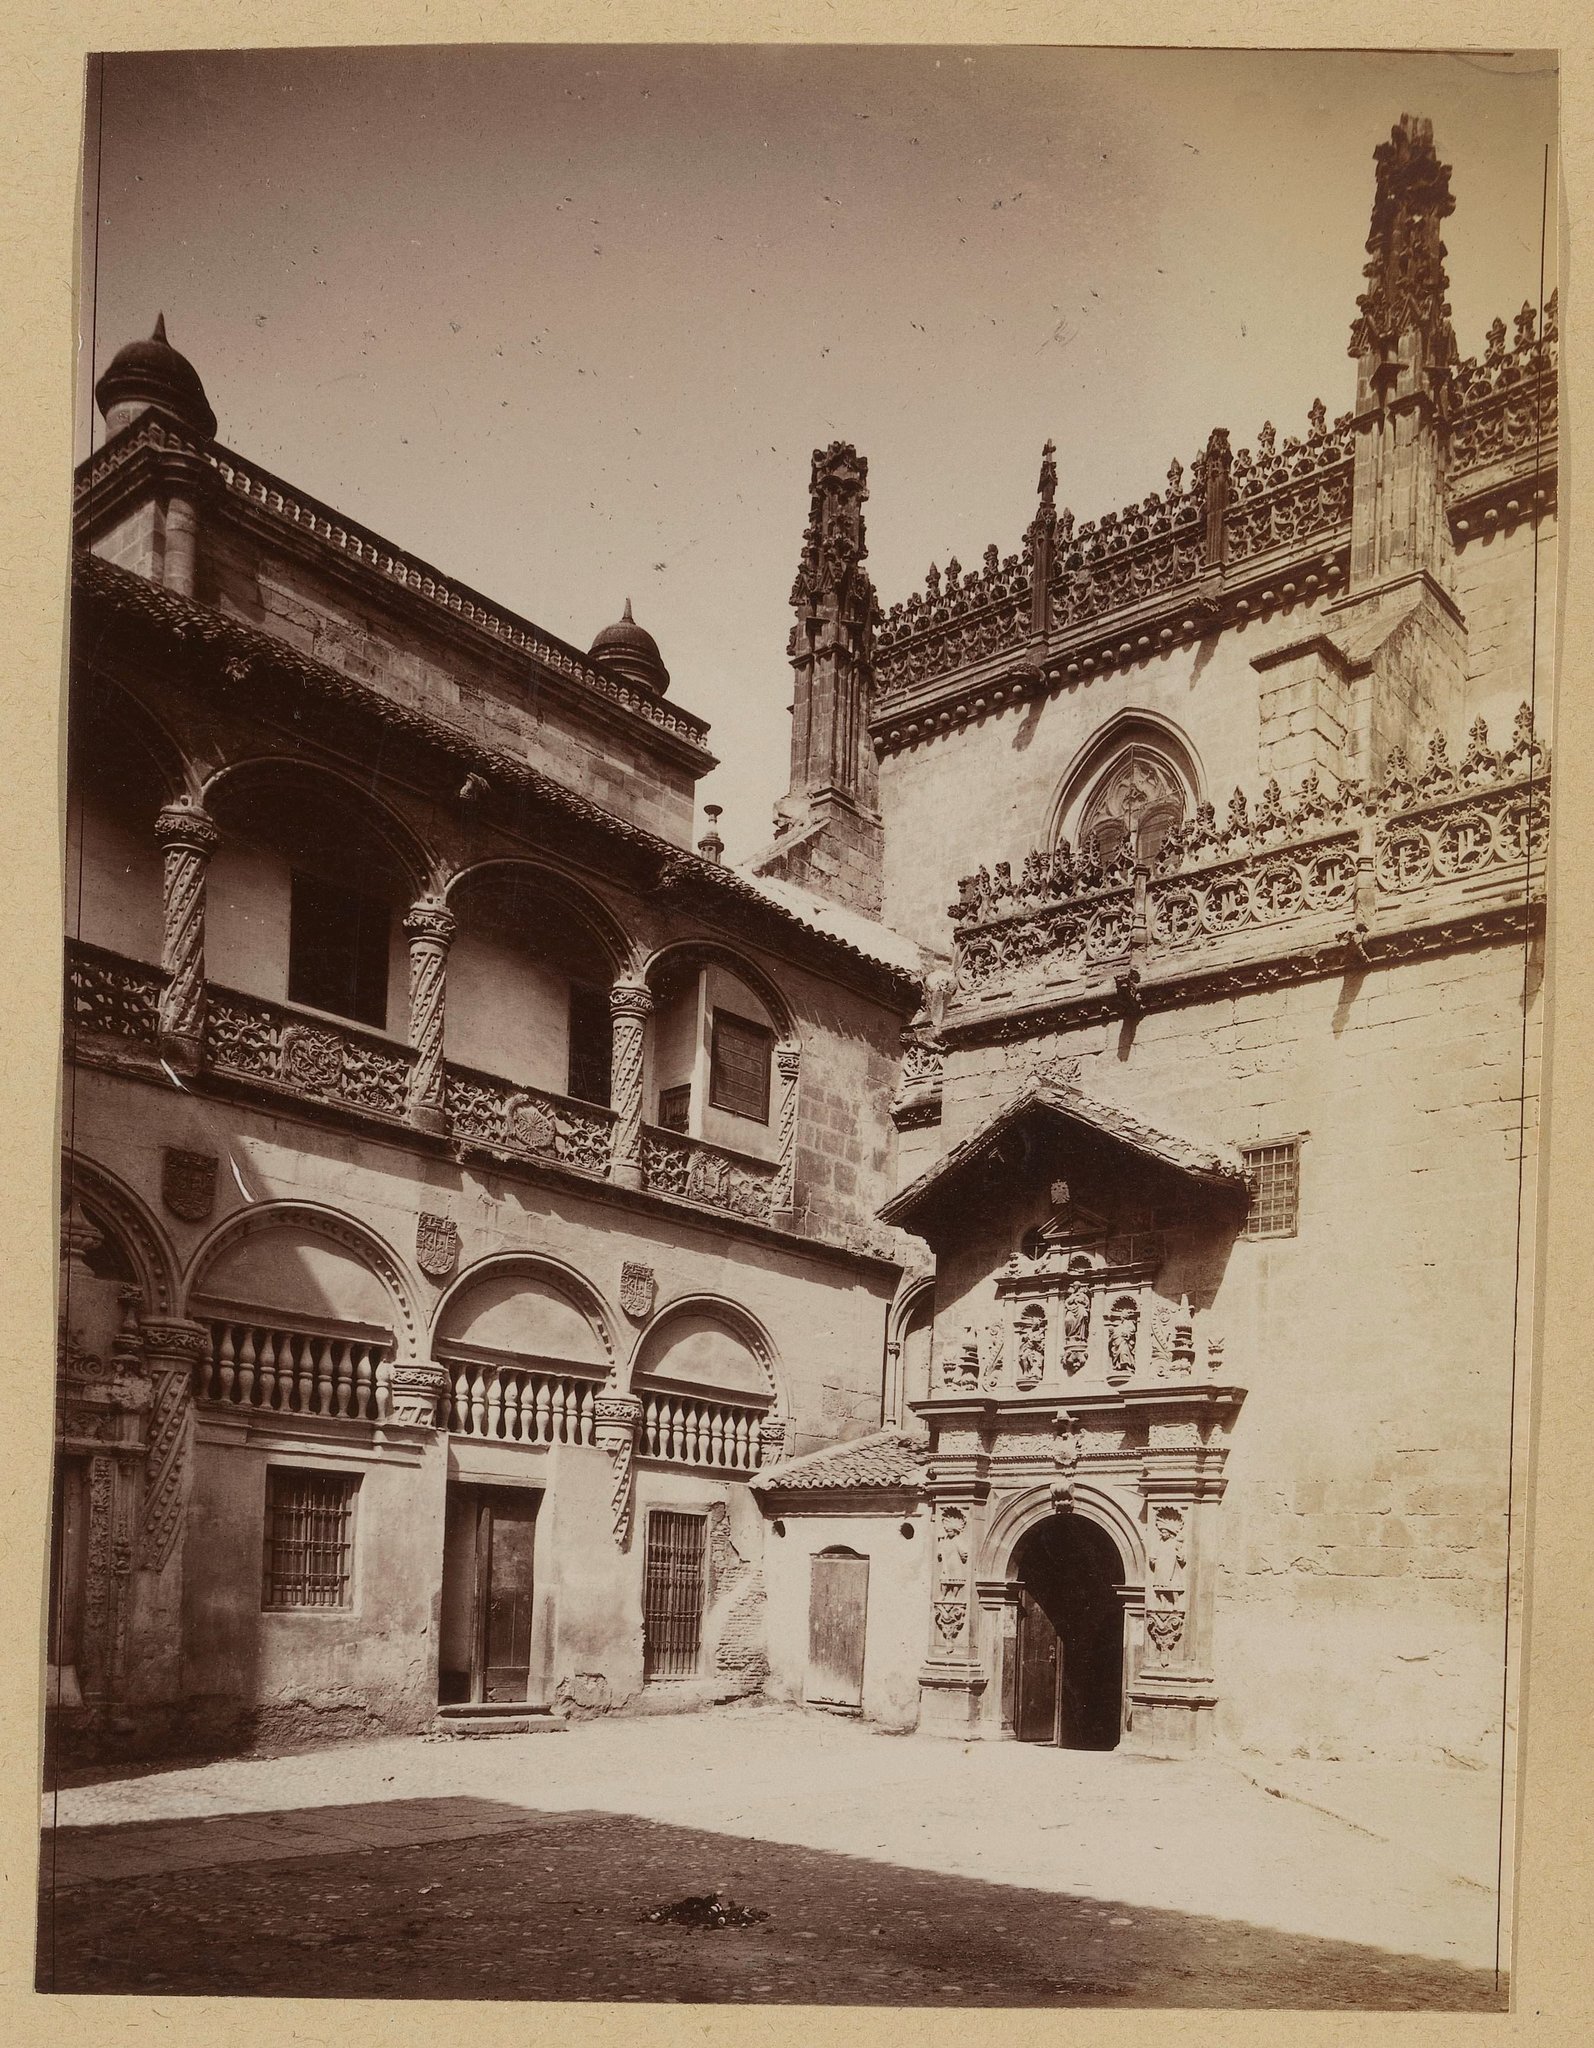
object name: photograph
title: Gezicht op de entrée van de koninklijke kapel in de kathedraal van Granada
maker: Anonymous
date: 1851-1890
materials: paper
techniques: albumen print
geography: granada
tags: parts of church exterior and annexes: chapel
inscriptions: inscription: ‘Exterior de la Capilla real/Grenada’